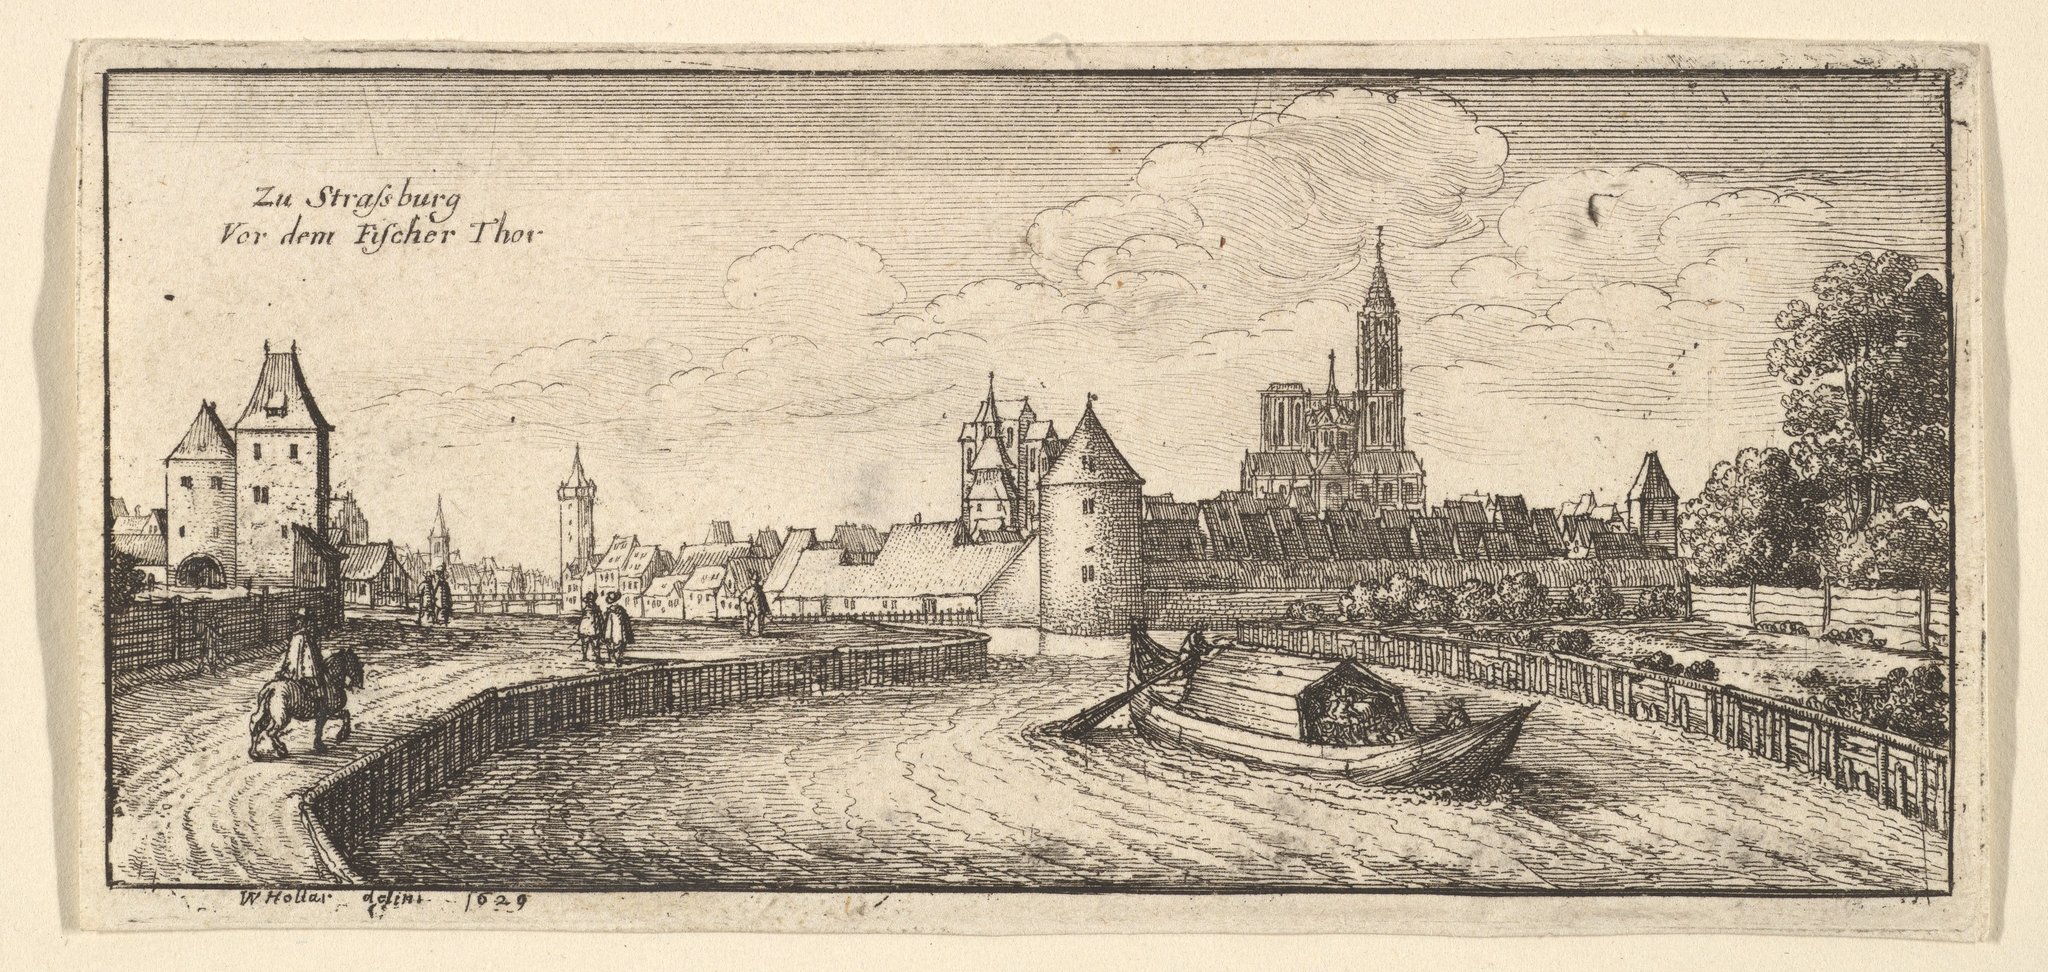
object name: print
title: Strasbourg, from "German Views"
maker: wenceslaus hollar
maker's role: artist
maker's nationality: bohemian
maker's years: 1607-1677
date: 1663-1665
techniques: etching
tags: buildings,cities,horses,rivers,boats